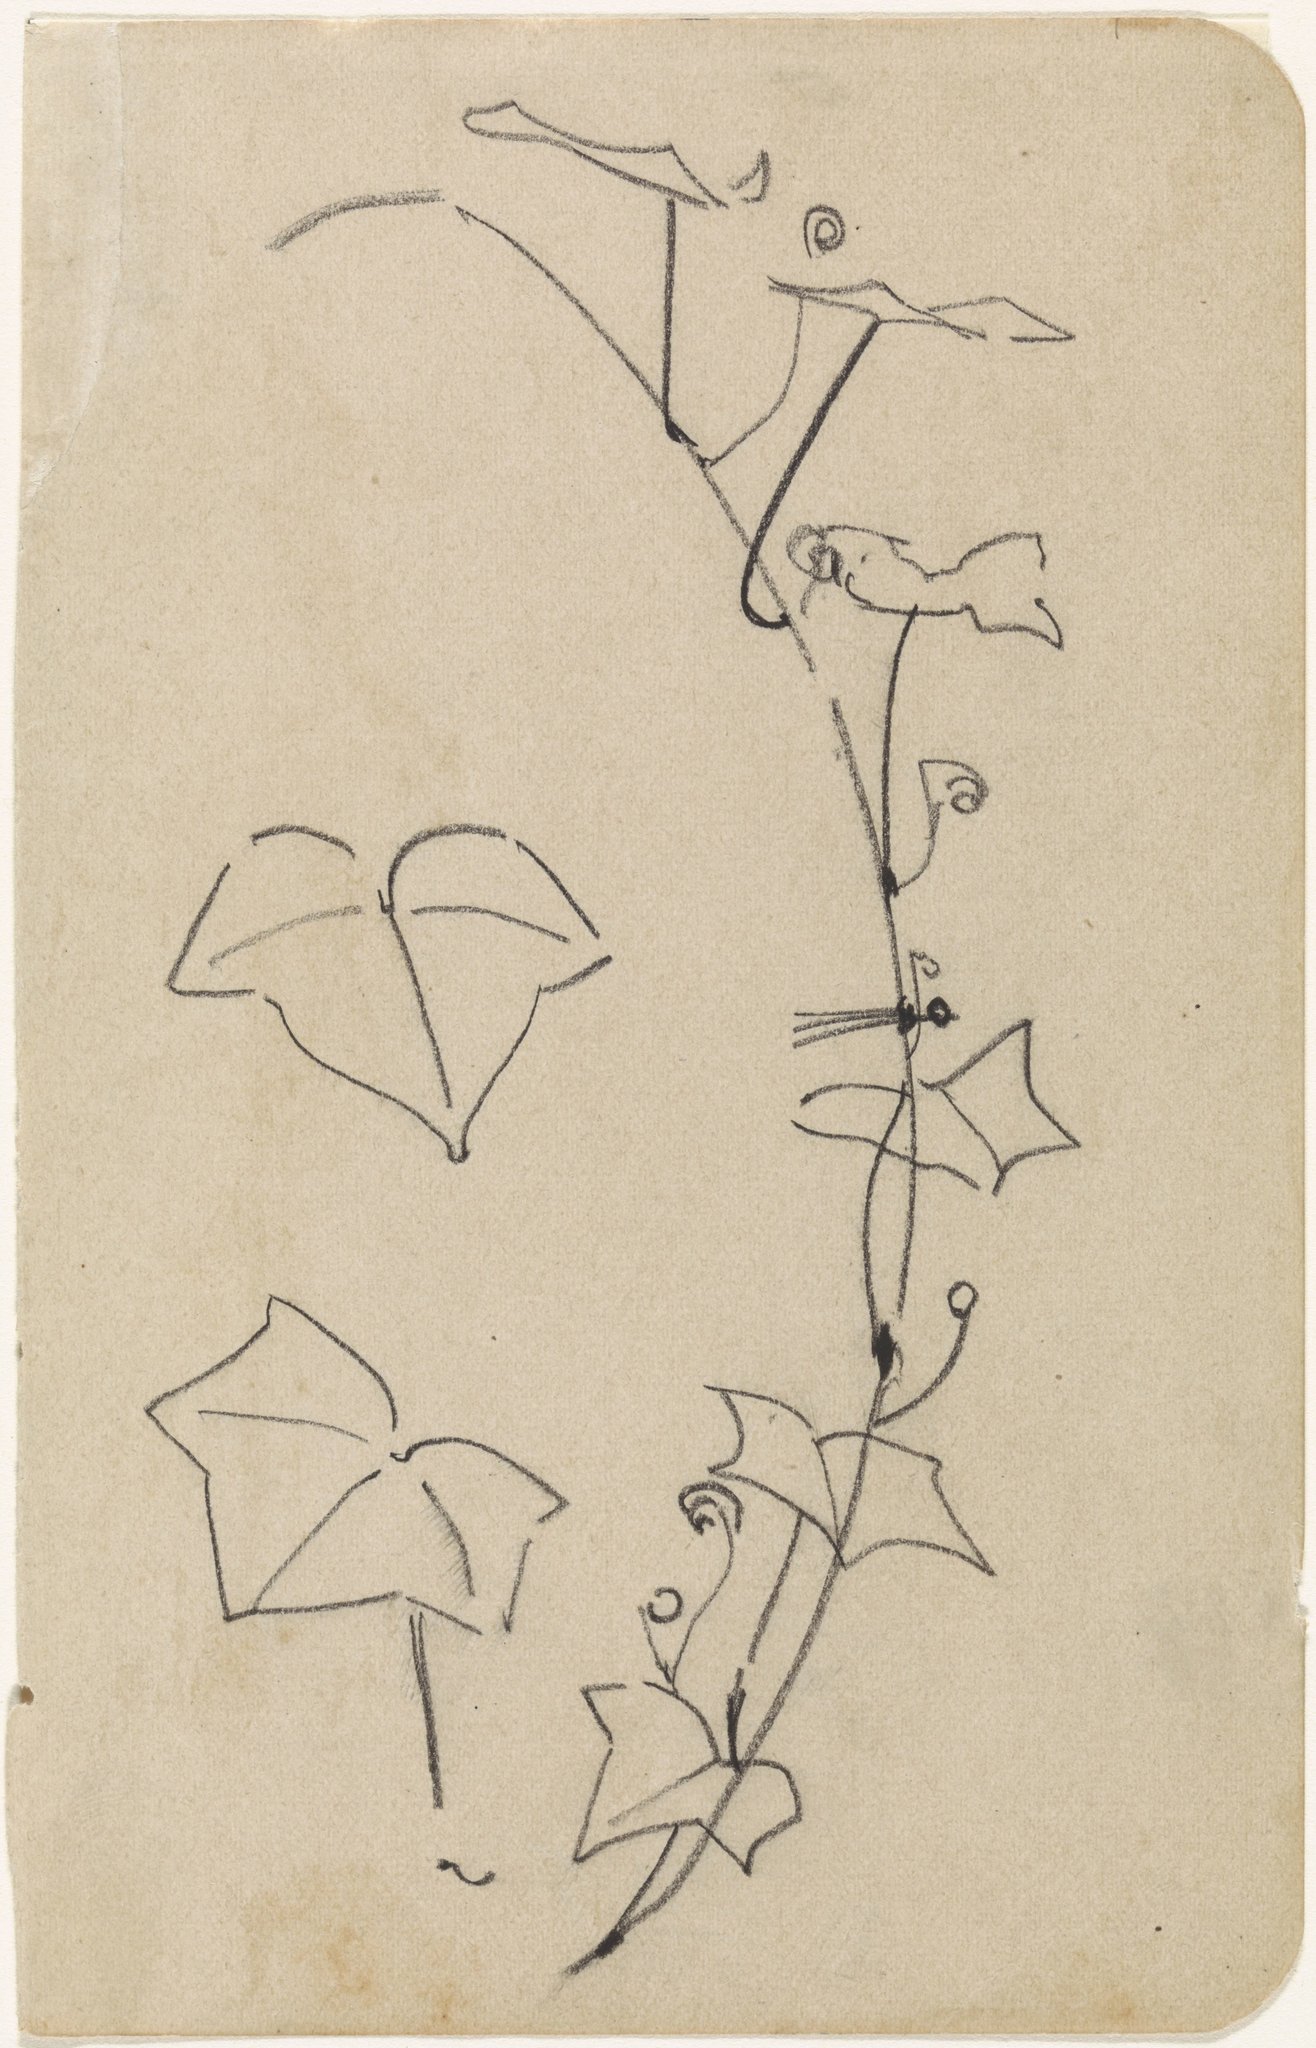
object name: drawing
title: Schets van klimop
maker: gerrit willem dijsselhof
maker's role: designer, draughtsman, print maker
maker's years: 1866-1924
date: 1876-1924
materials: chalk, paper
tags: plants and herbs: ivy